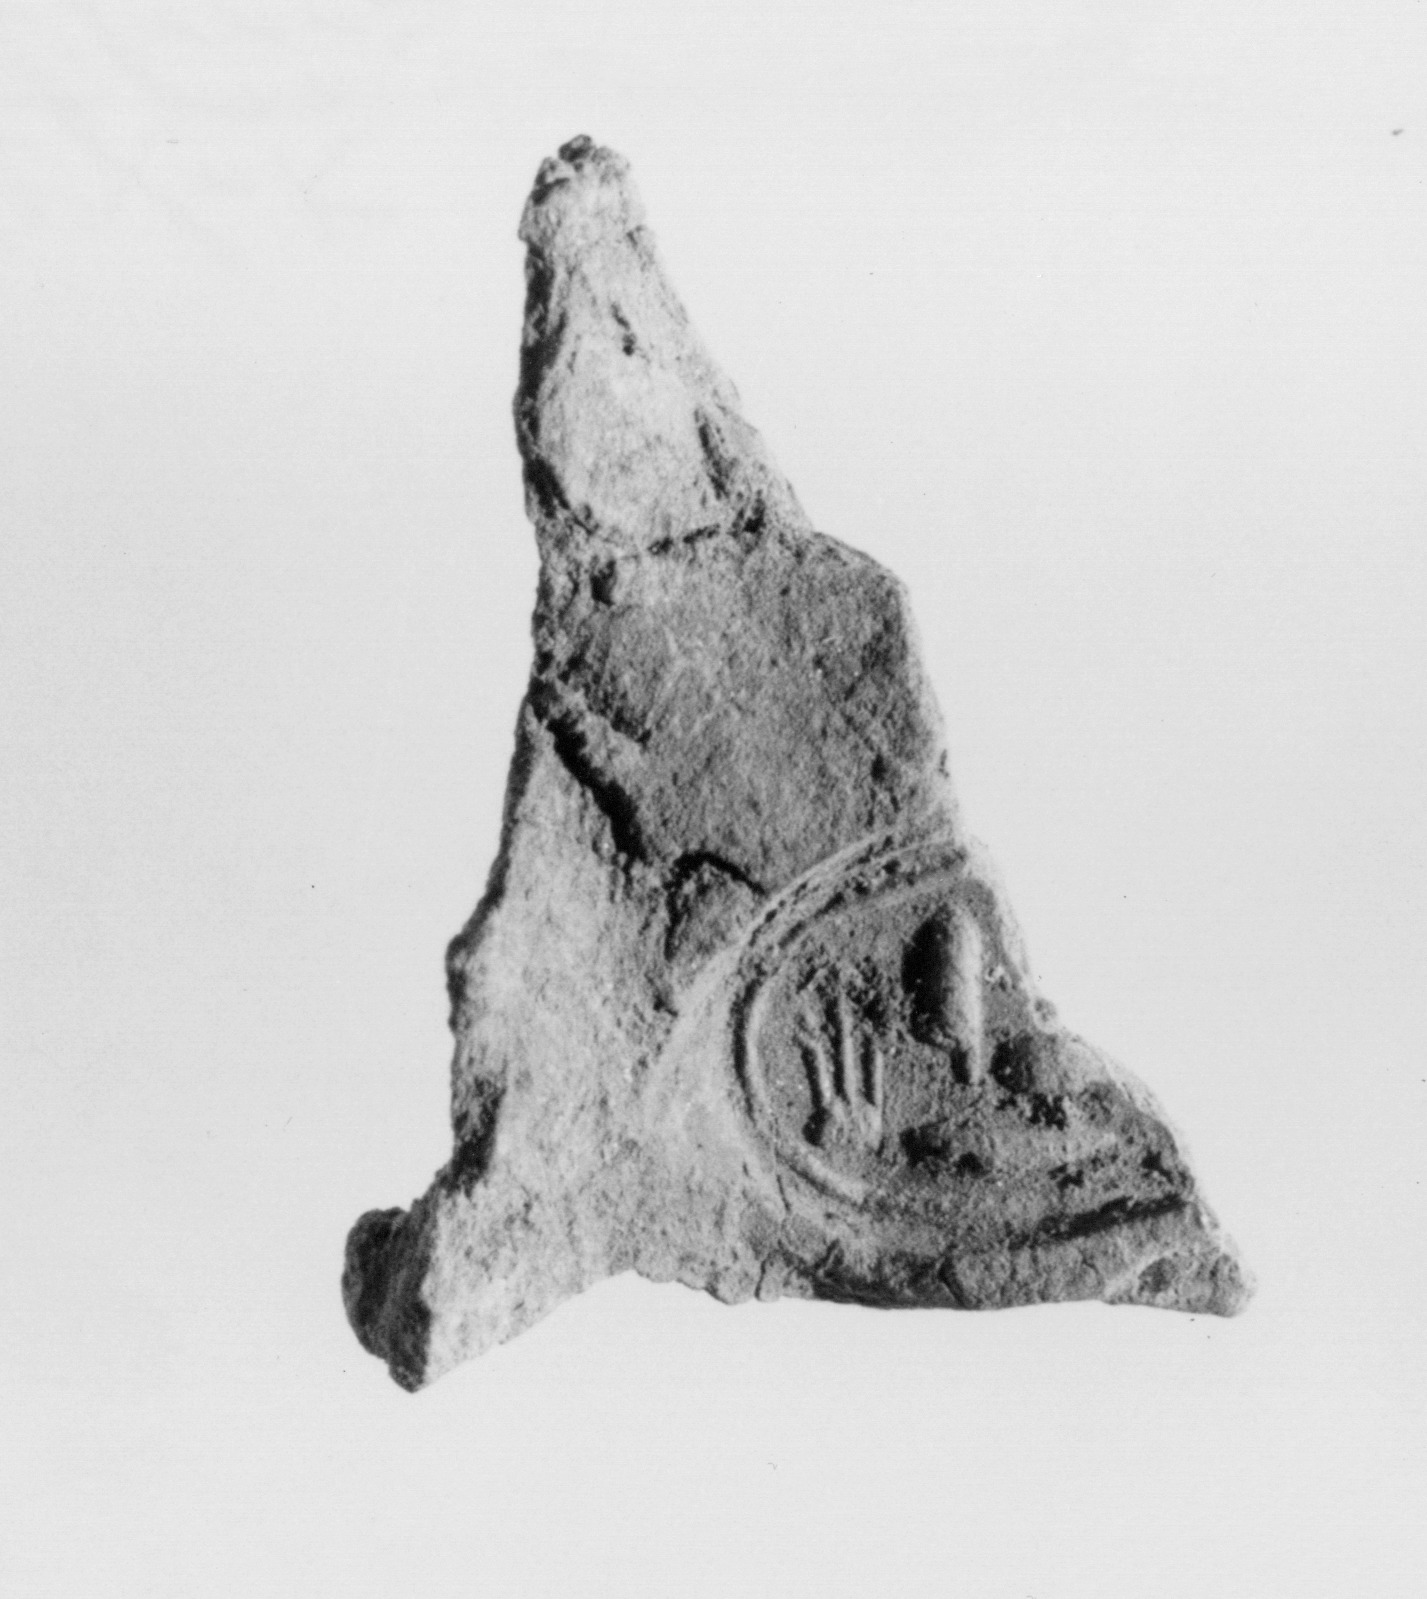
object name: sealing, upper egypt, lower egypt, amun re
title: Document Sealing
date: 1390-1352 BCE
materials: mud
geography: egypt